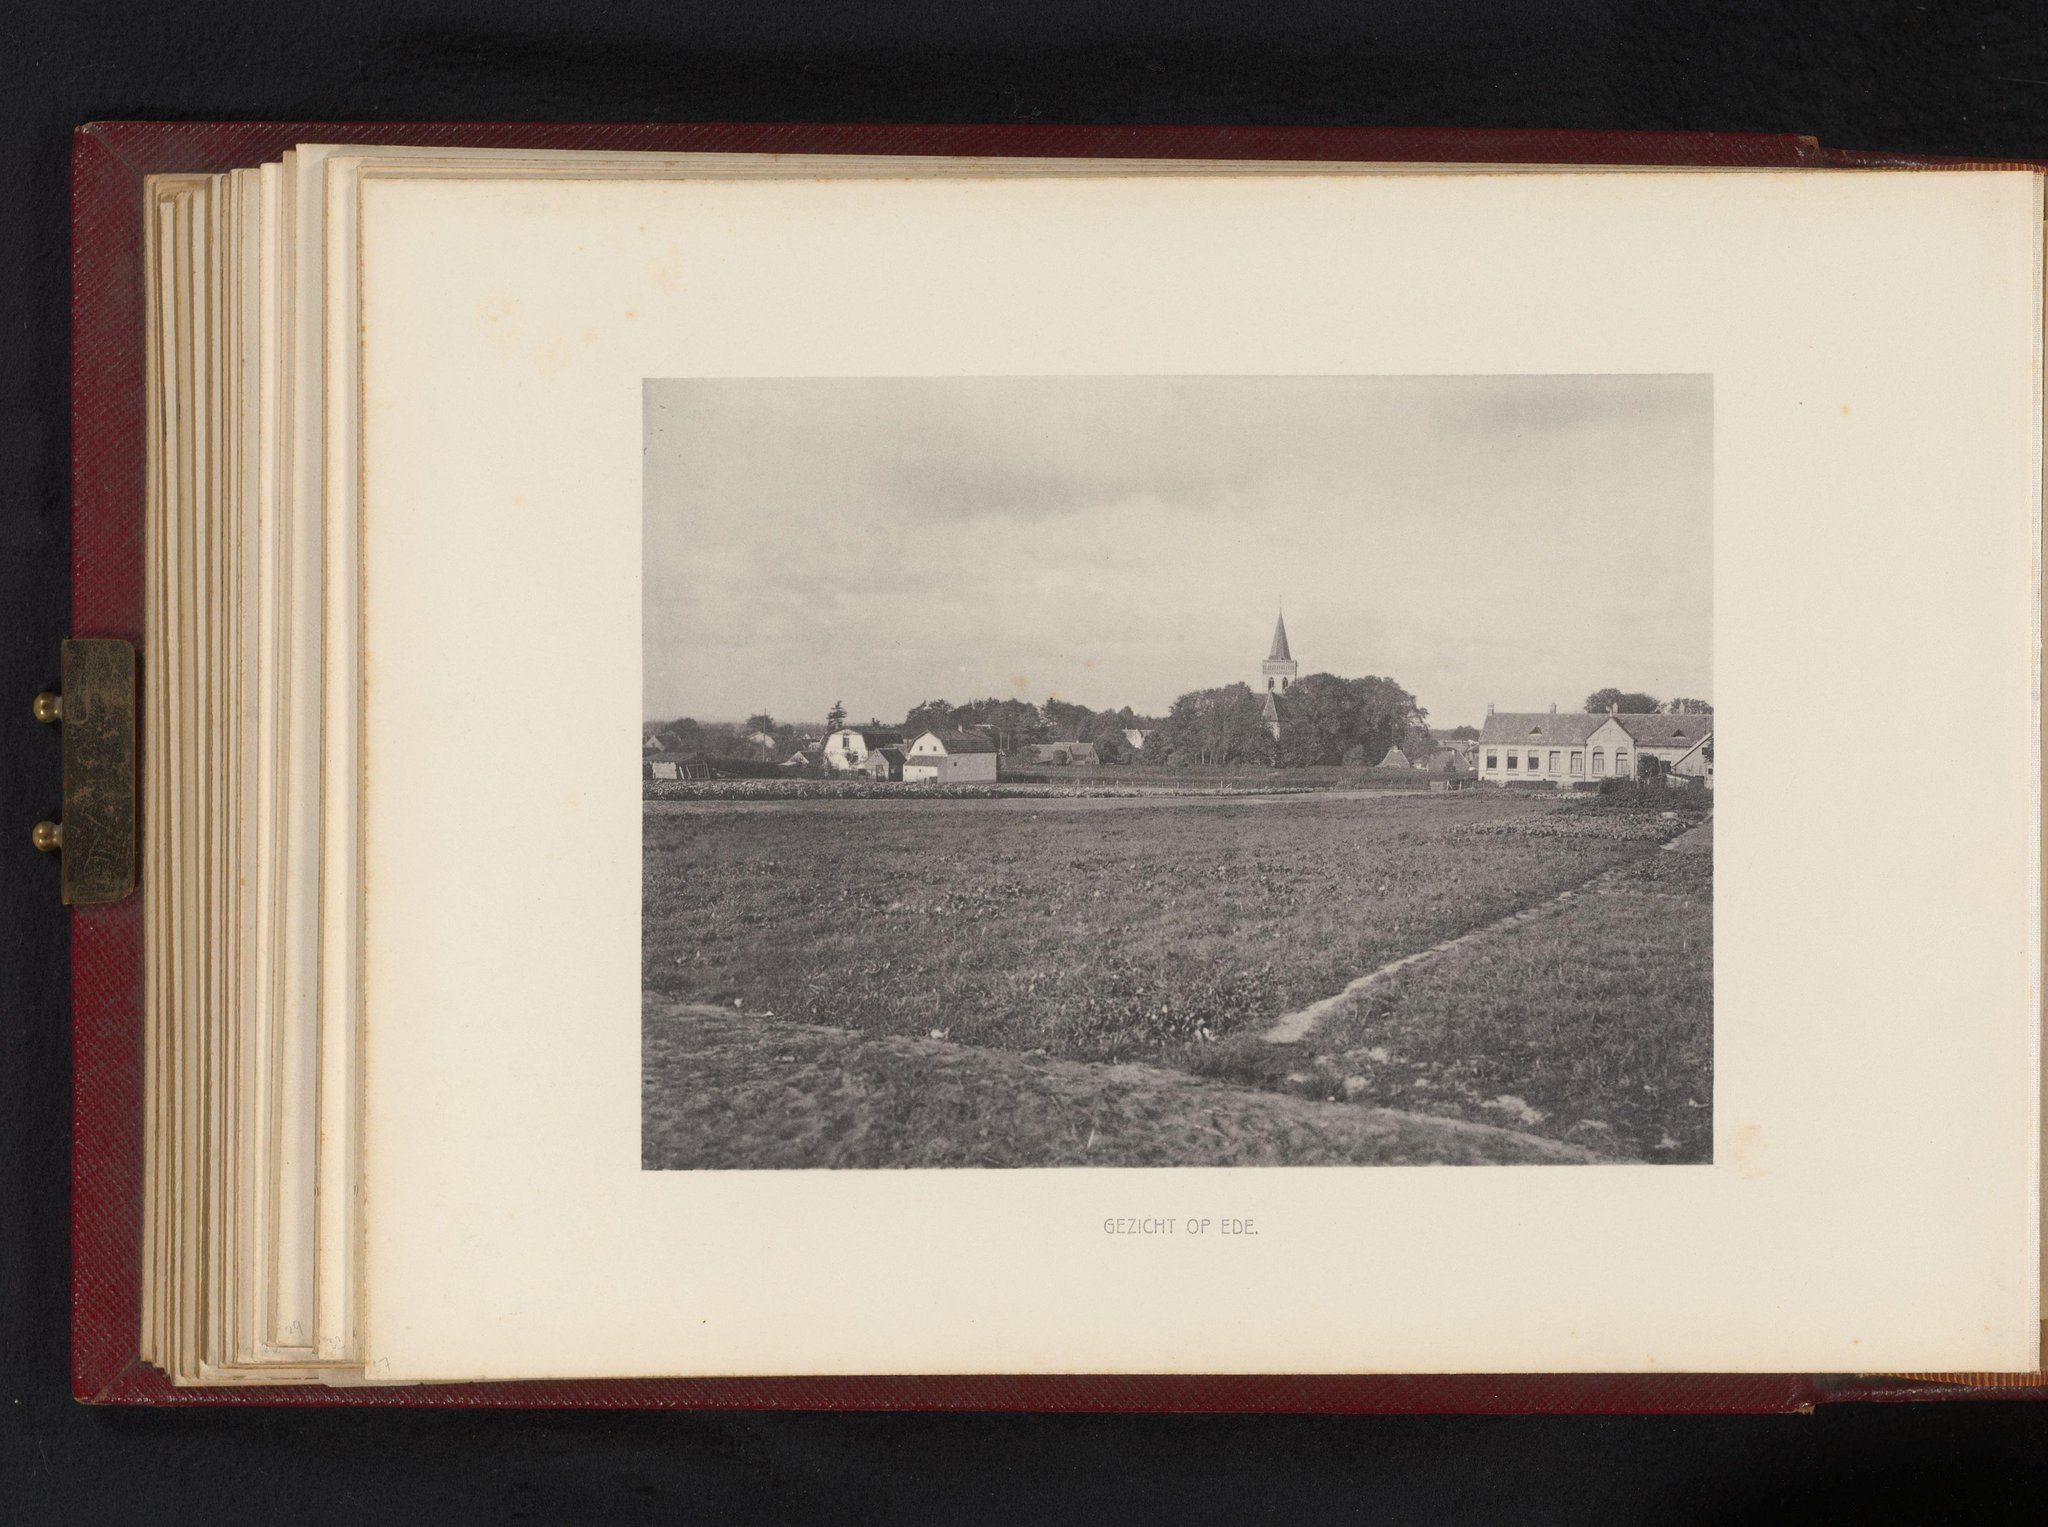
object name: album leaf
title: Gezicht op Ede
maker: Anonymous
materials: paper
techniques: photograph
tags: city-view in general; 'veduta'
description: Deze pagina maakt deel uit van een album.